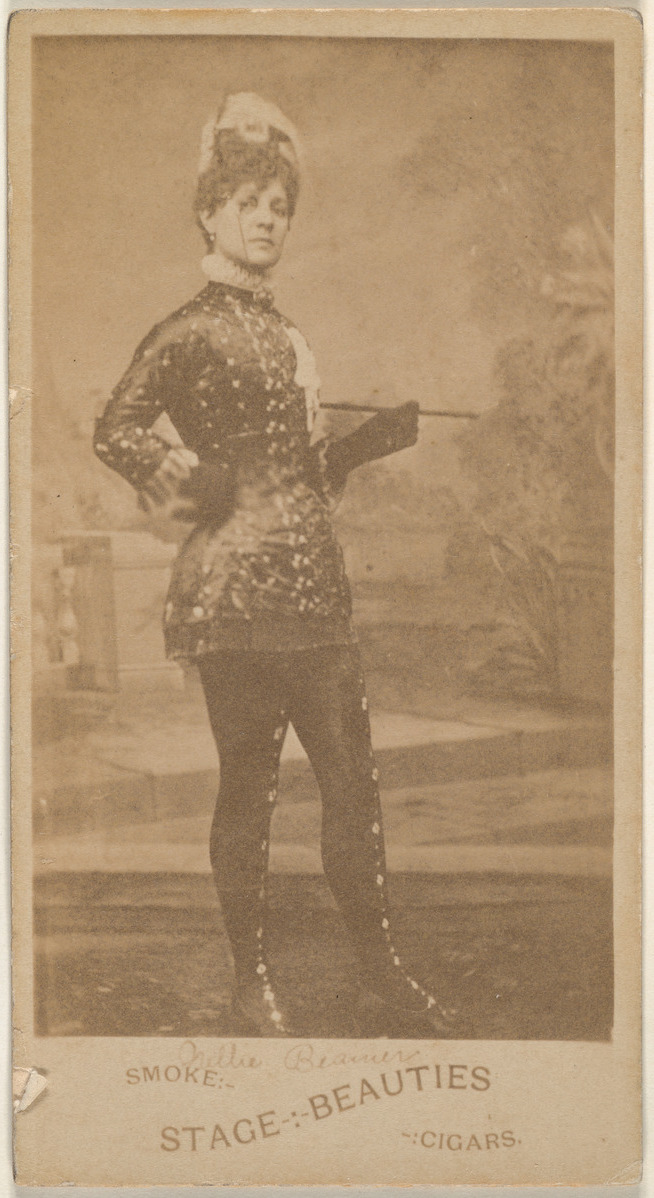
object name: photograph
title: Actress standing with hand on hip, from the Actresses series (N666) to promote Stage Beauties Cigars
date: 1888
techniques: albumen silver print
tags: portraits,women,actresses